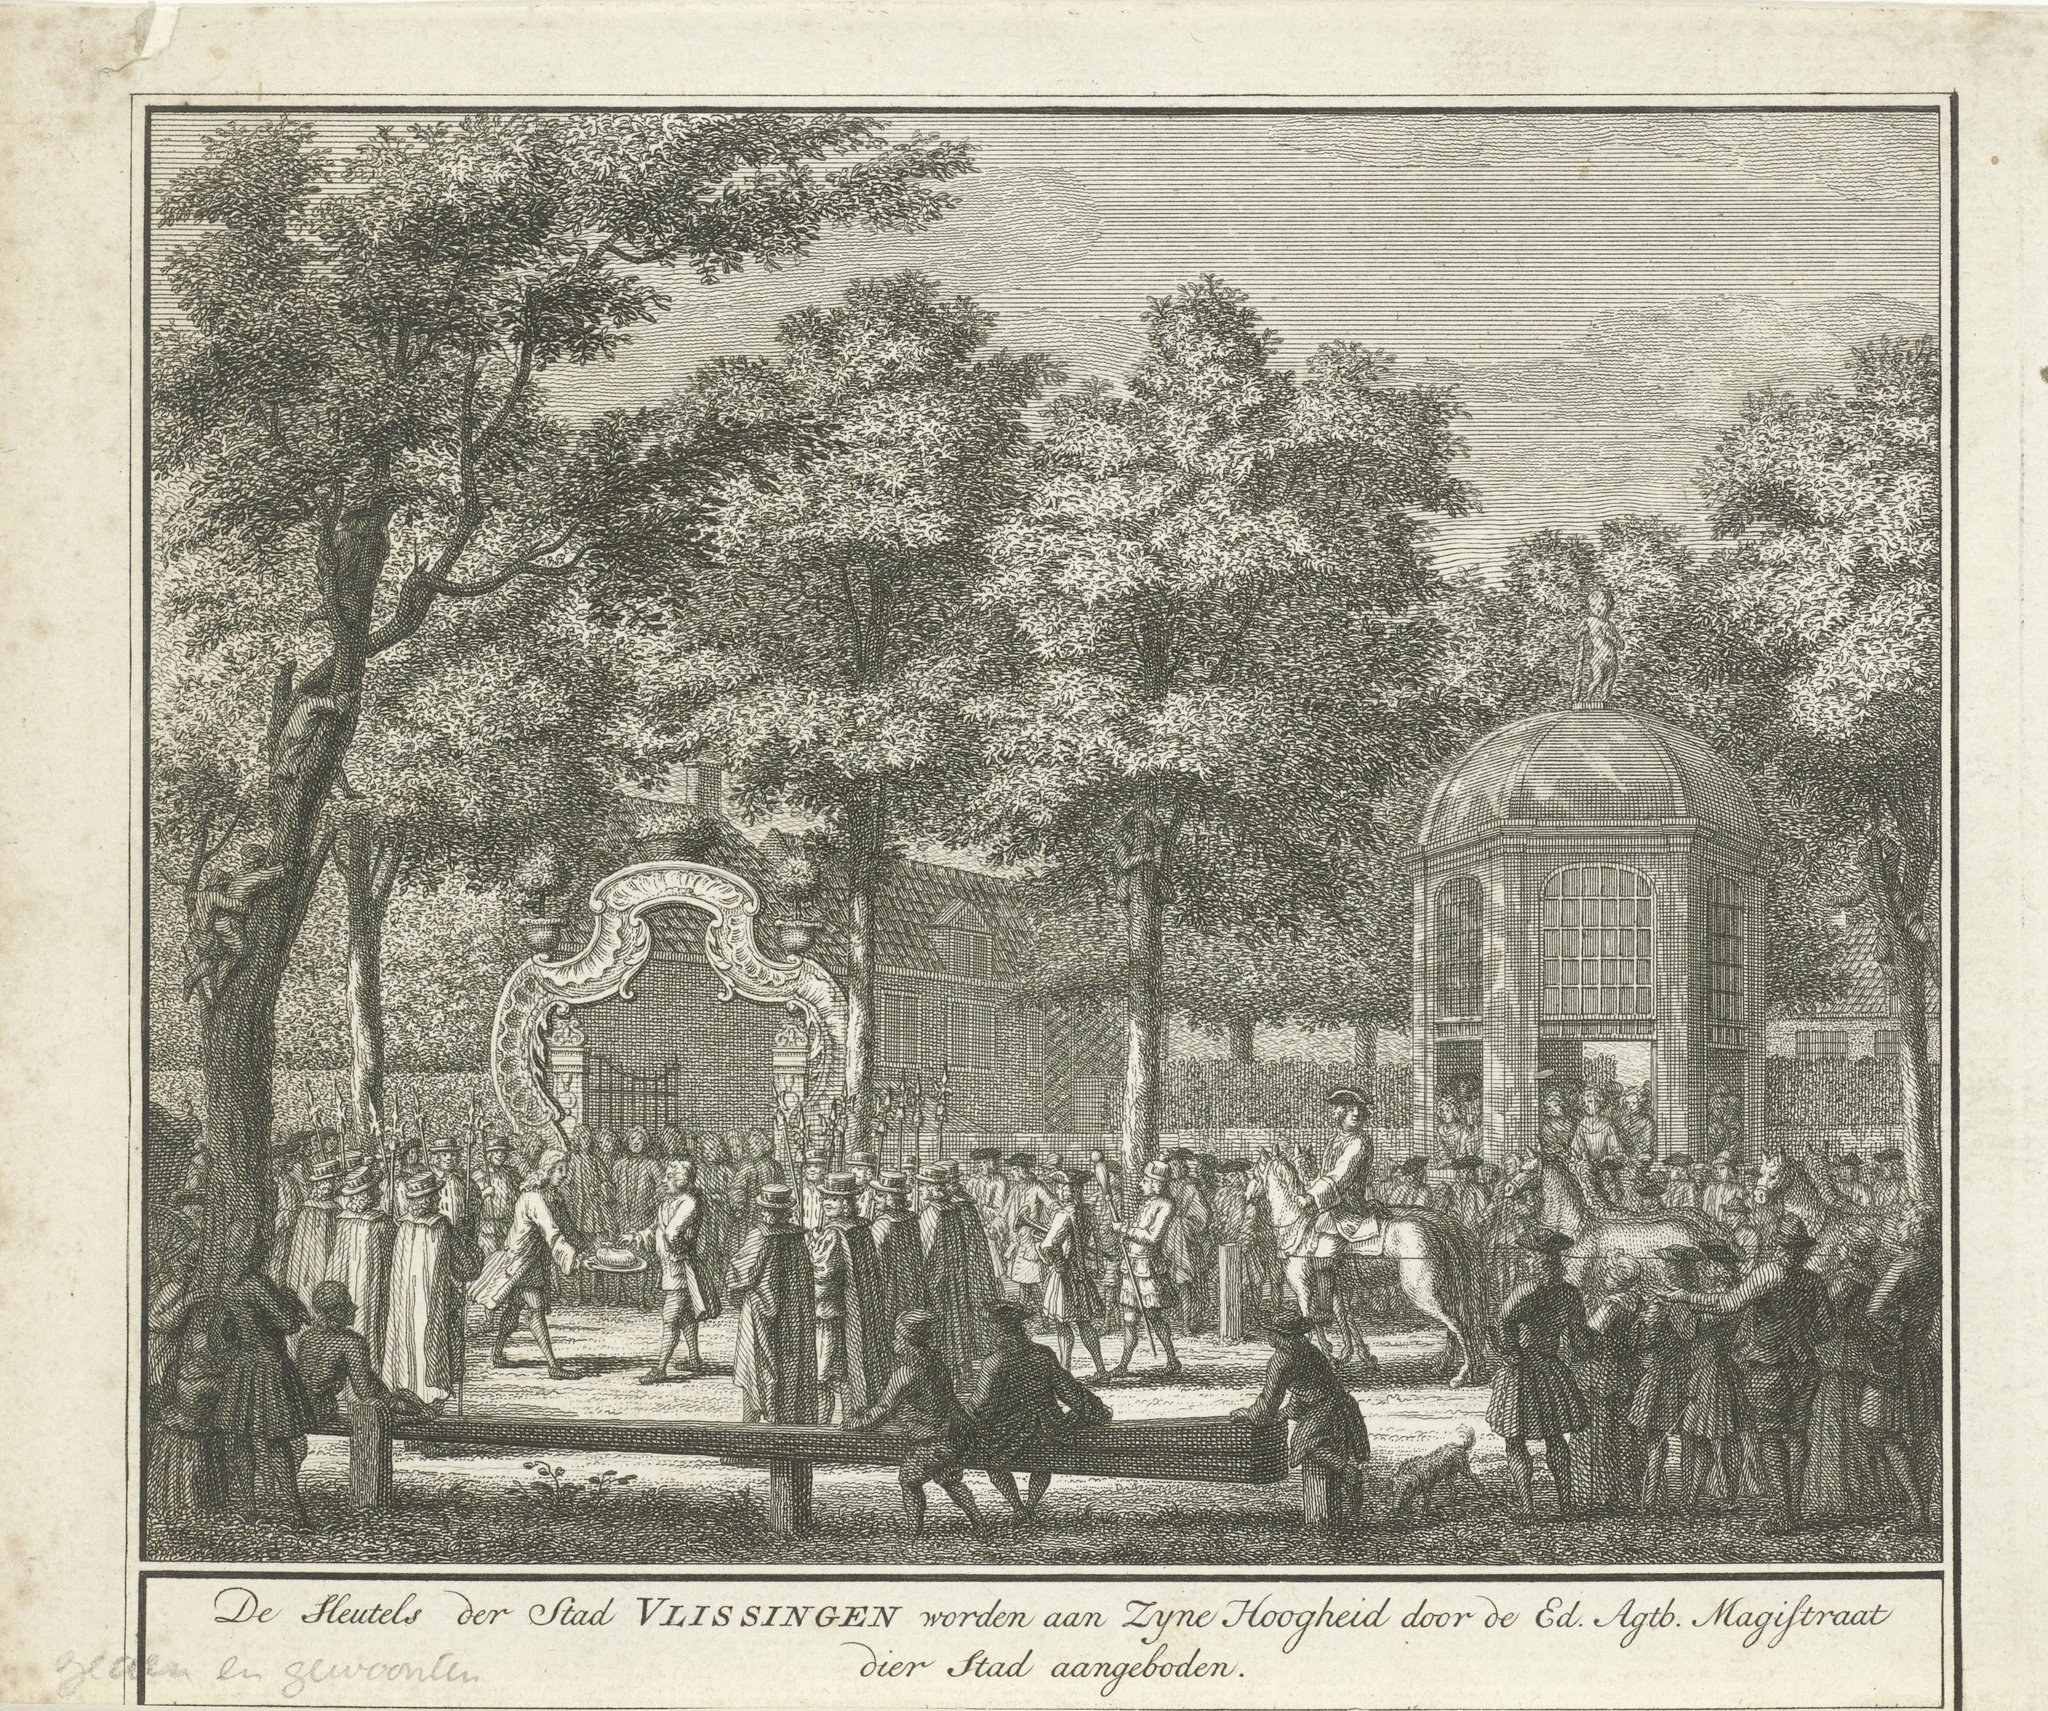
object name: print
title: Aanbieden van de sleutels aan Willem IV, 1751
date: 1753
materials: paper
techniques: engraving, etching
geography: amsterdam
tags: willem iv (prins van oranje-nassau), triumphal entry and public reception, pageant, 'entrée solennelle', 'joyeuse entrée', surrender of keys, flushing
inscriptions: collector's mark: Lugt 2228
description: Illustratie afkomstig uit: Huët, Daniel Théodore. Inhuldiging van zijne doorluchtige hoogheid Willem Karel Hendrik Friso (...) als erf-heer van Vlissingen, op den Vden junij MDCCLI. Amsterdam: Isaak Tirion, 1753.